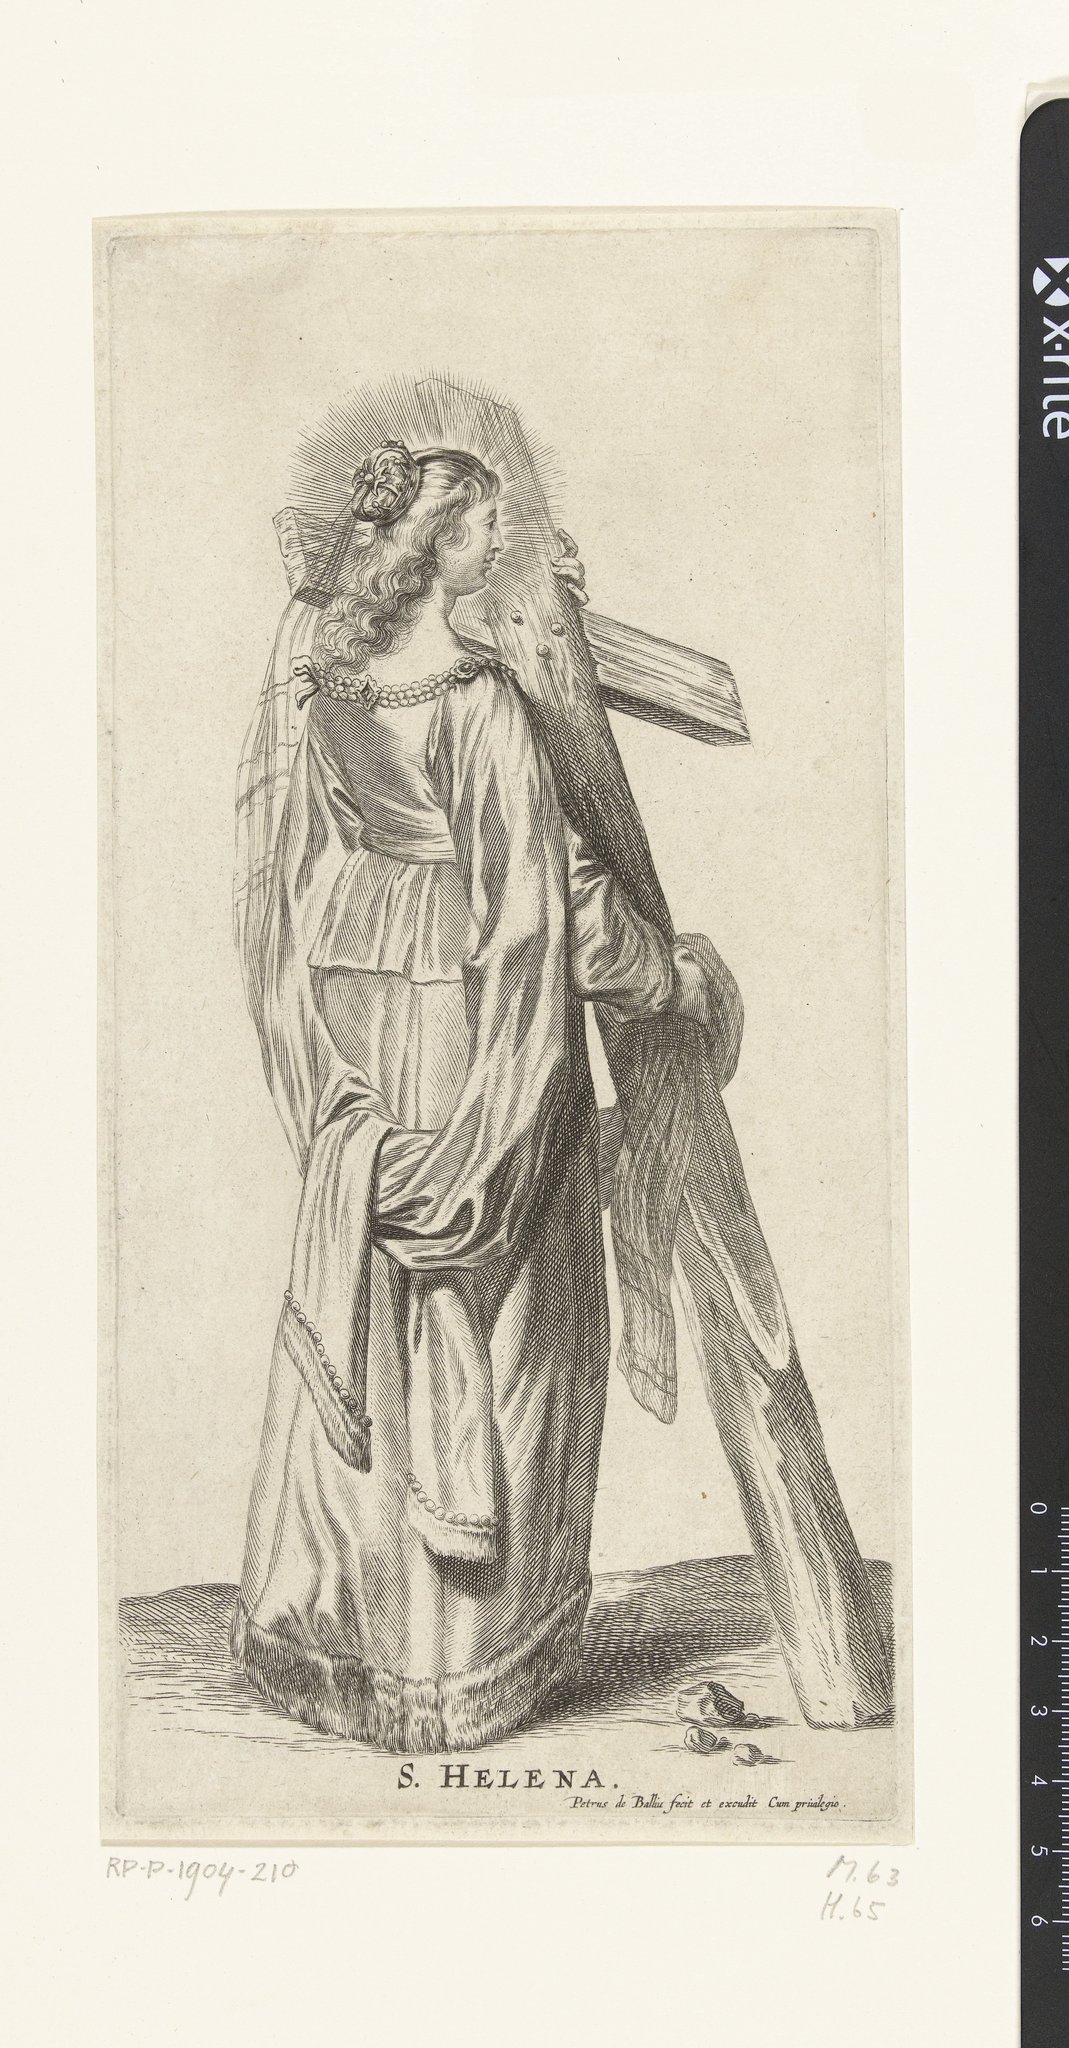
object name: print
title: Heilige Helena met kruis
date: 1623-1660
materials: paper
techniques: engraving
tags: empress helena, mother of constantine the great; possible attributes: model of church, (royal) crown, crown of thorns, cross, three nails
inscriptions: collector's mark: Lugt 2228